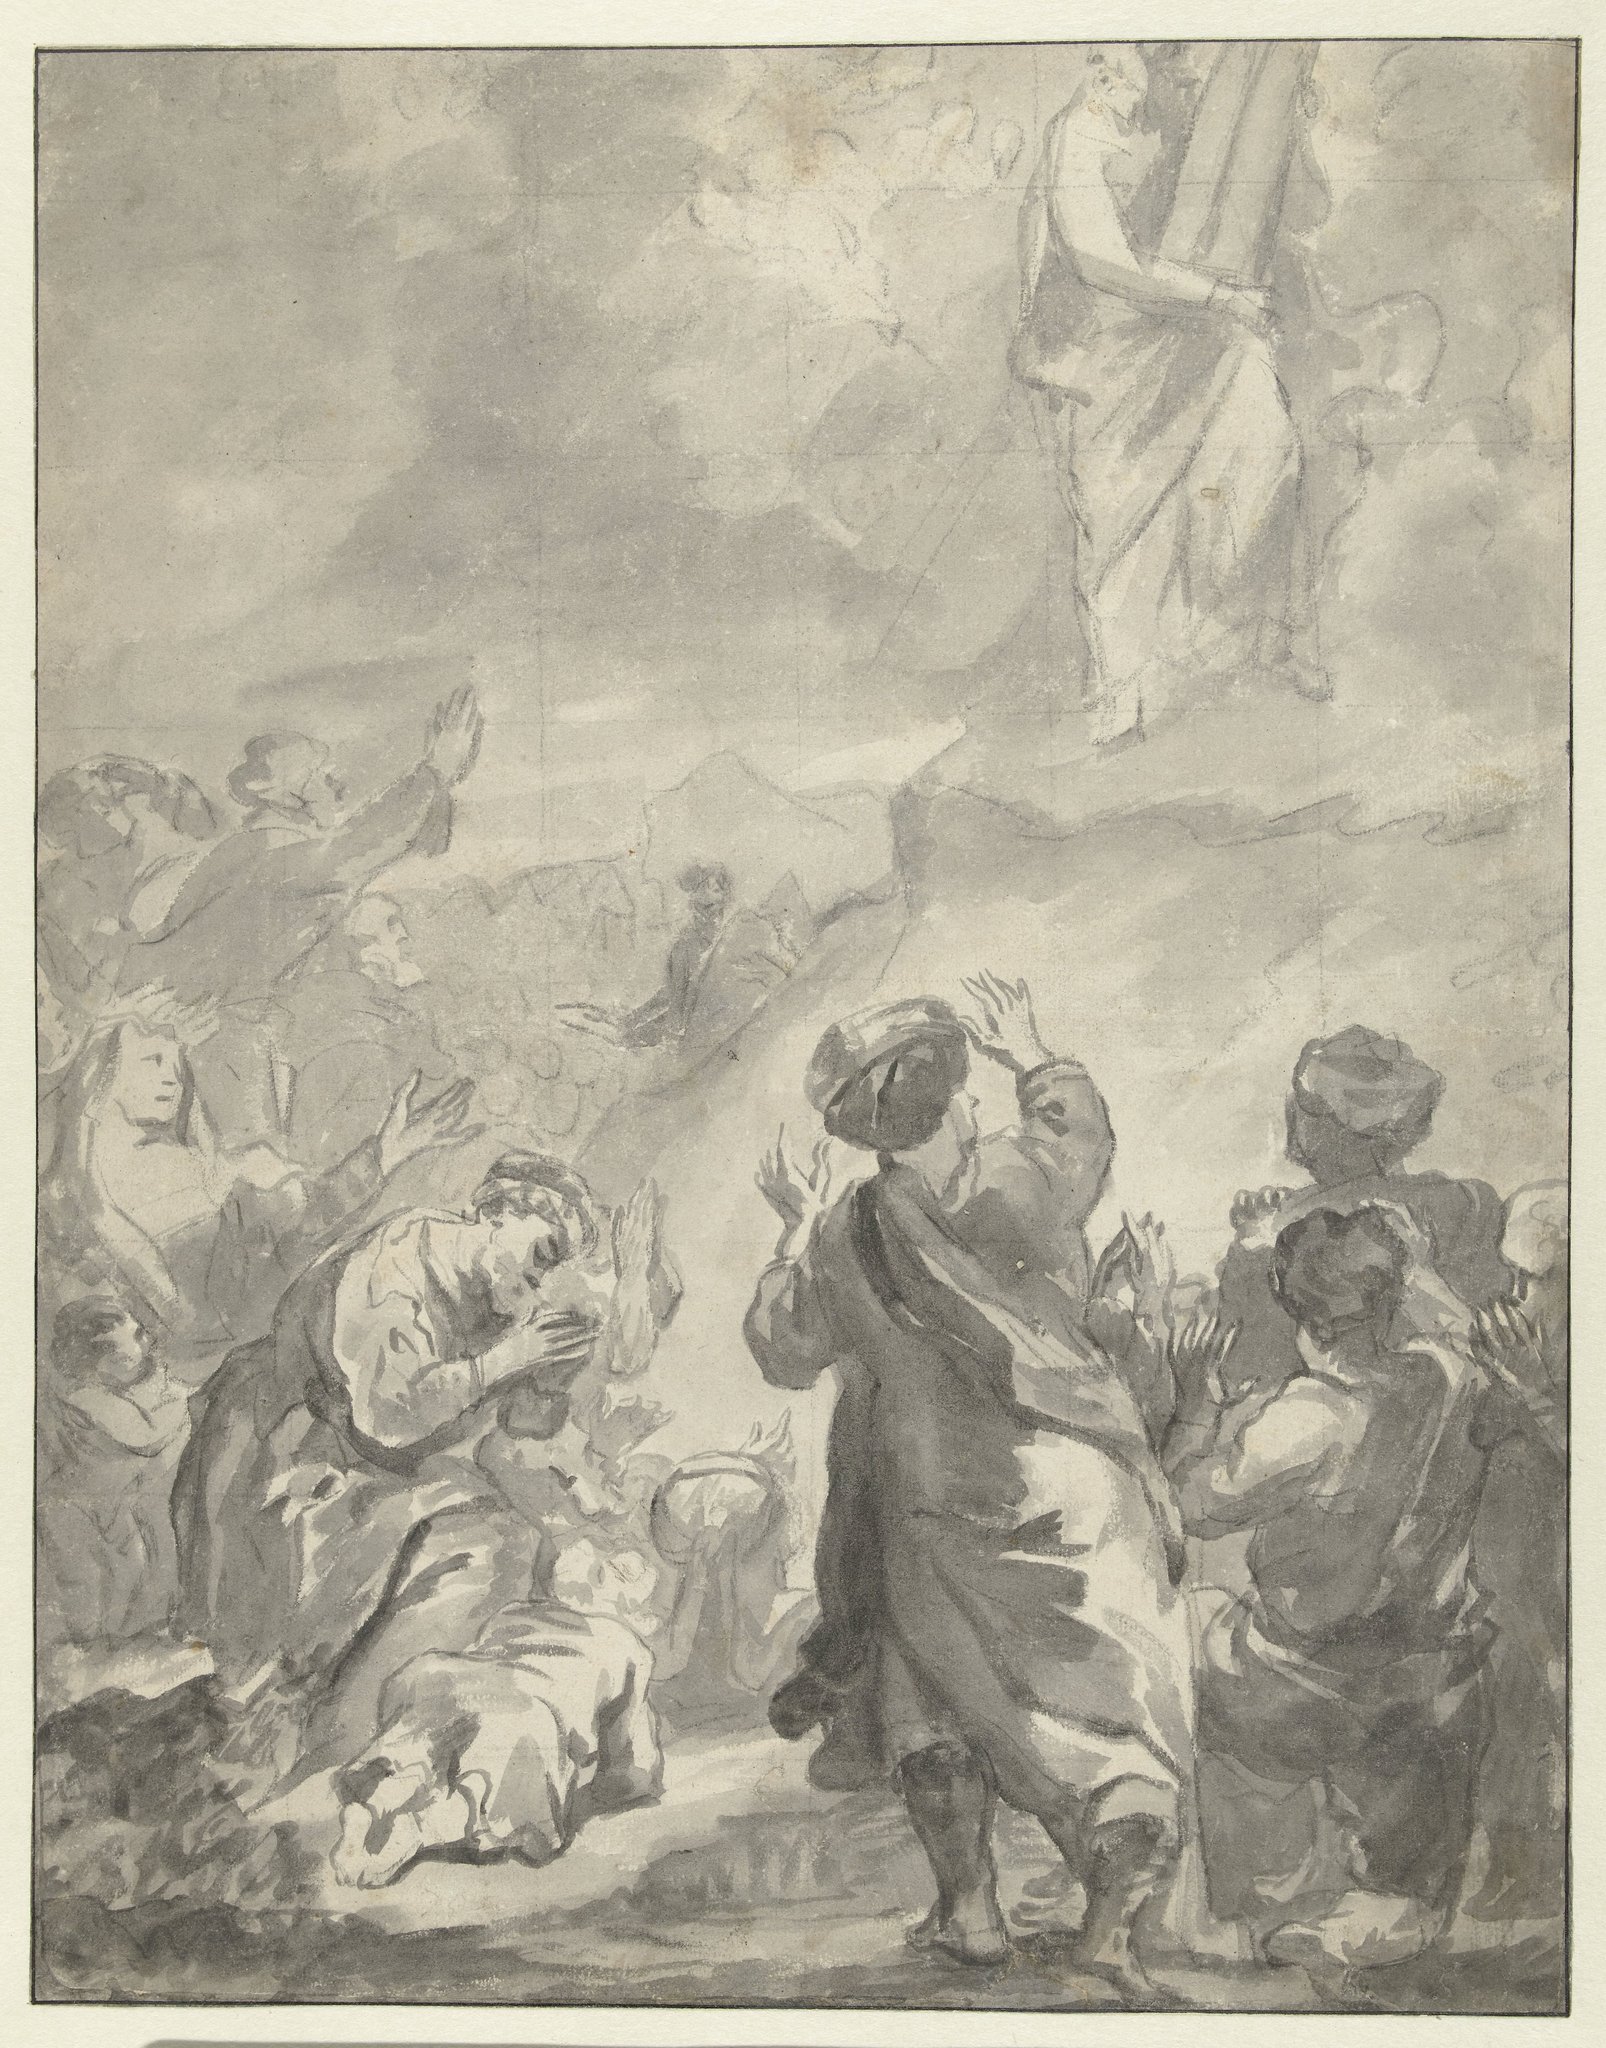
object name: drawing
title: Moses Descending from Mount Sinai with the Ten Commandments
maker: ferdinand bol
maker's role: draughtsman, painter, print maker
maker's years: 1616-1680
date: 1664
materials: chalk, ink, paper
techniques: brush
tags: moses on mount sinai with the tables of the law (exodus 24:9-18, 31:18)